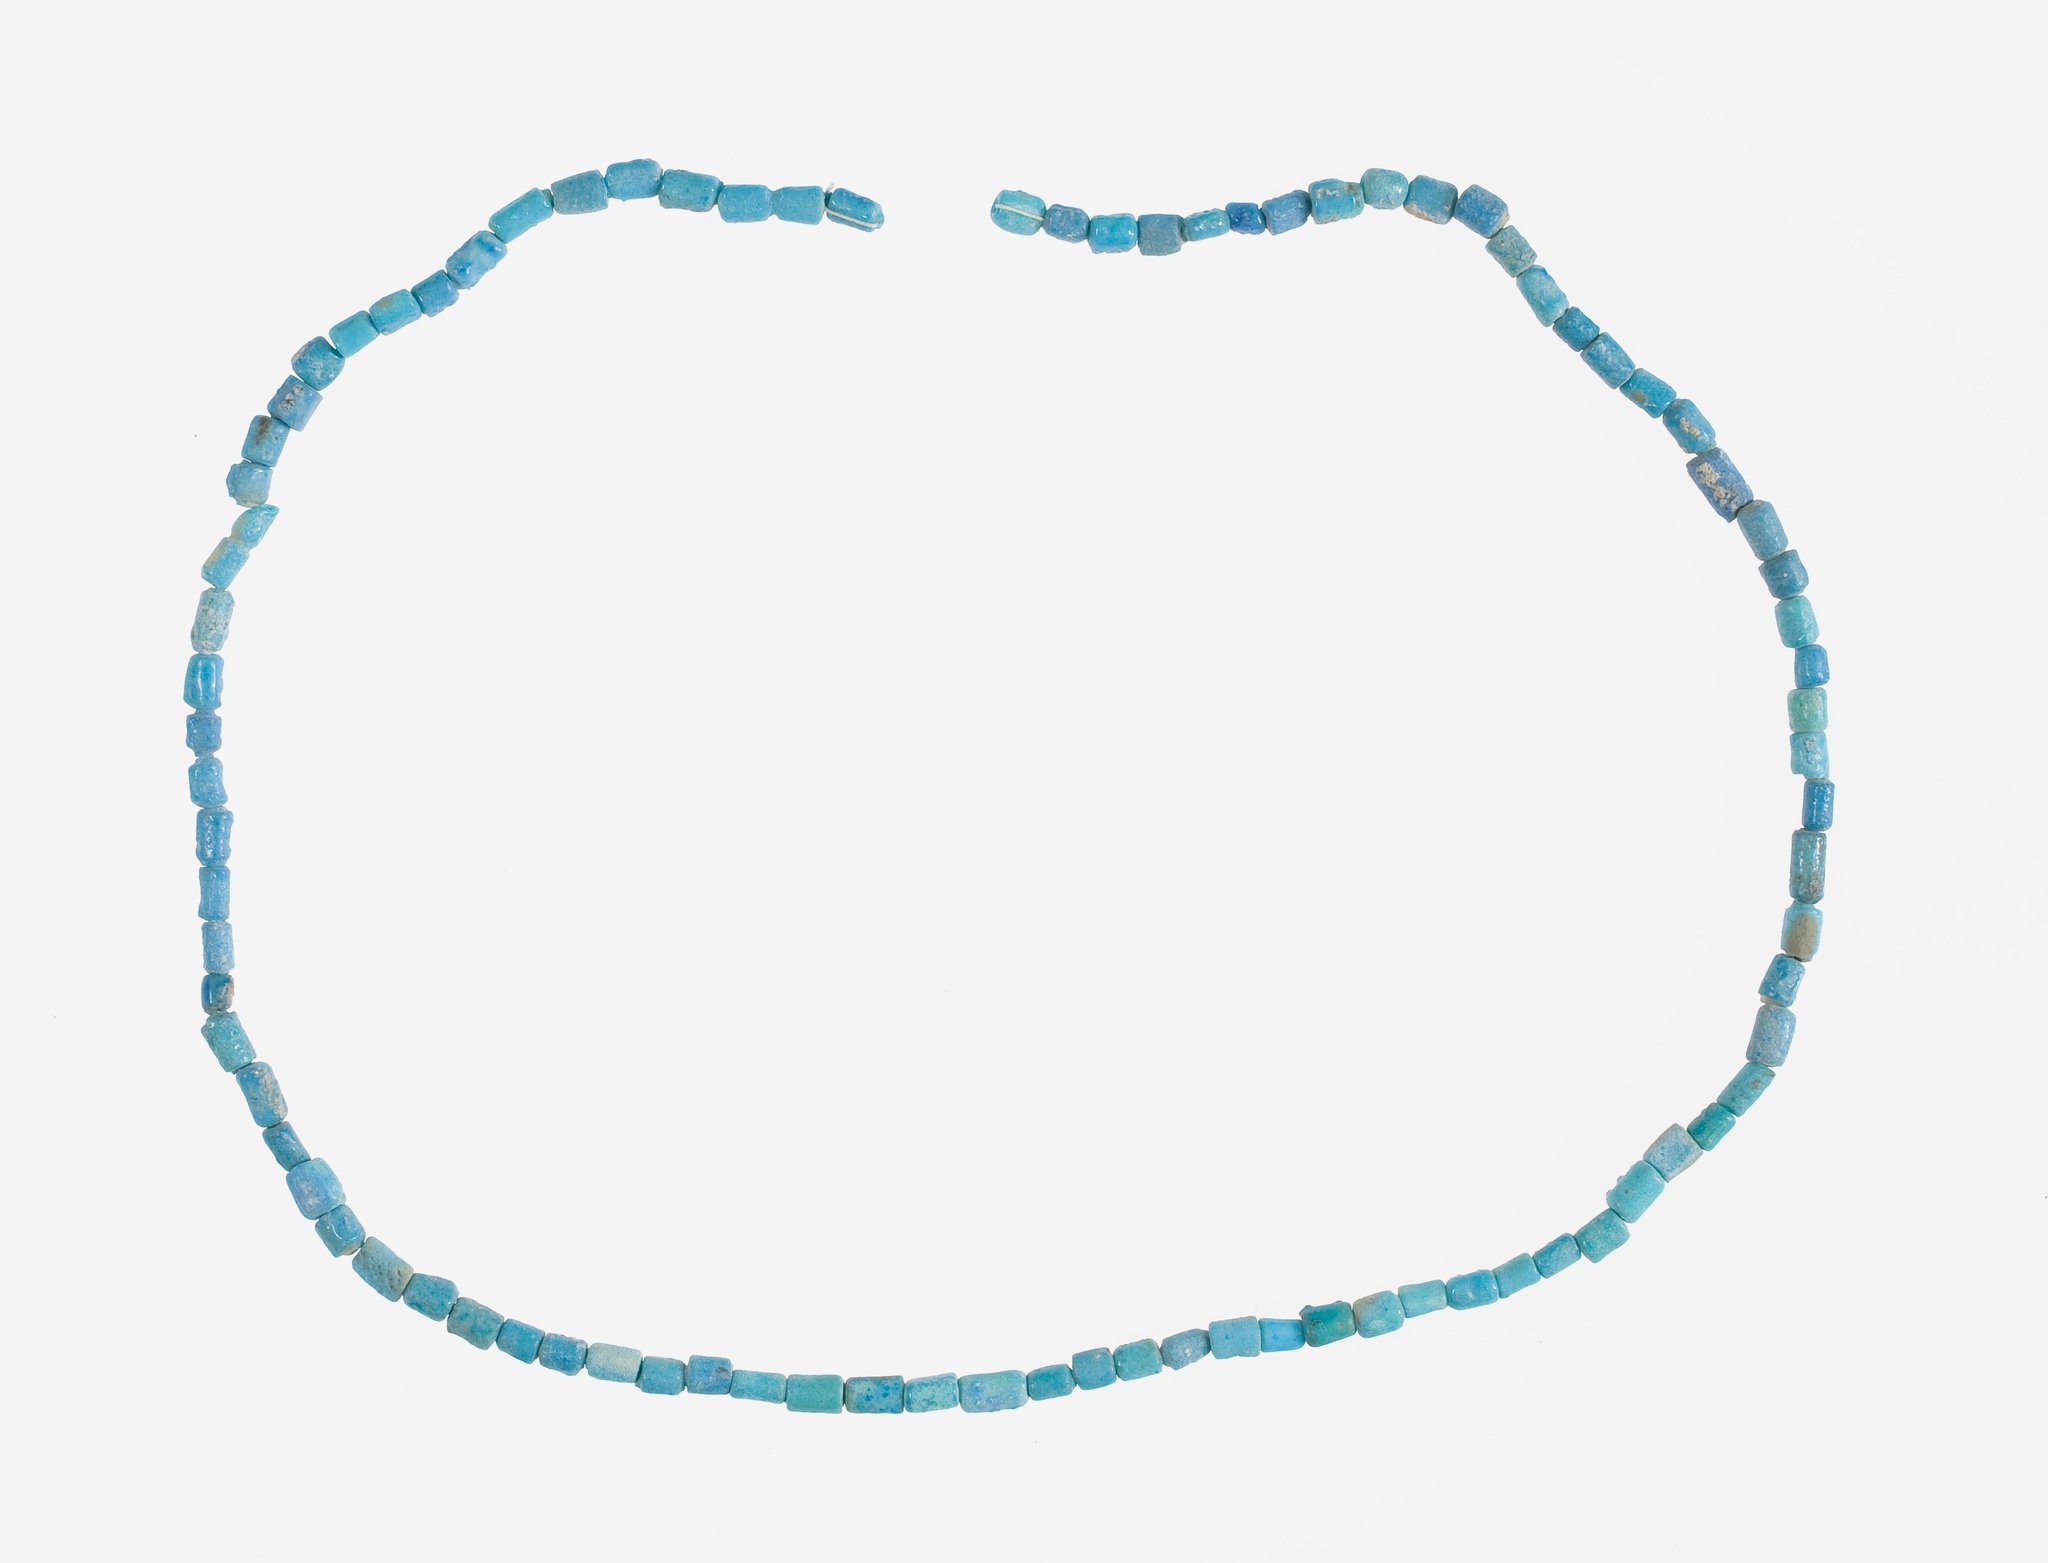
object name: bead, cylinder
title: String of Short Cylindrical Beads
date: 1390-1352 BCE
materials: faience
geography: egypt